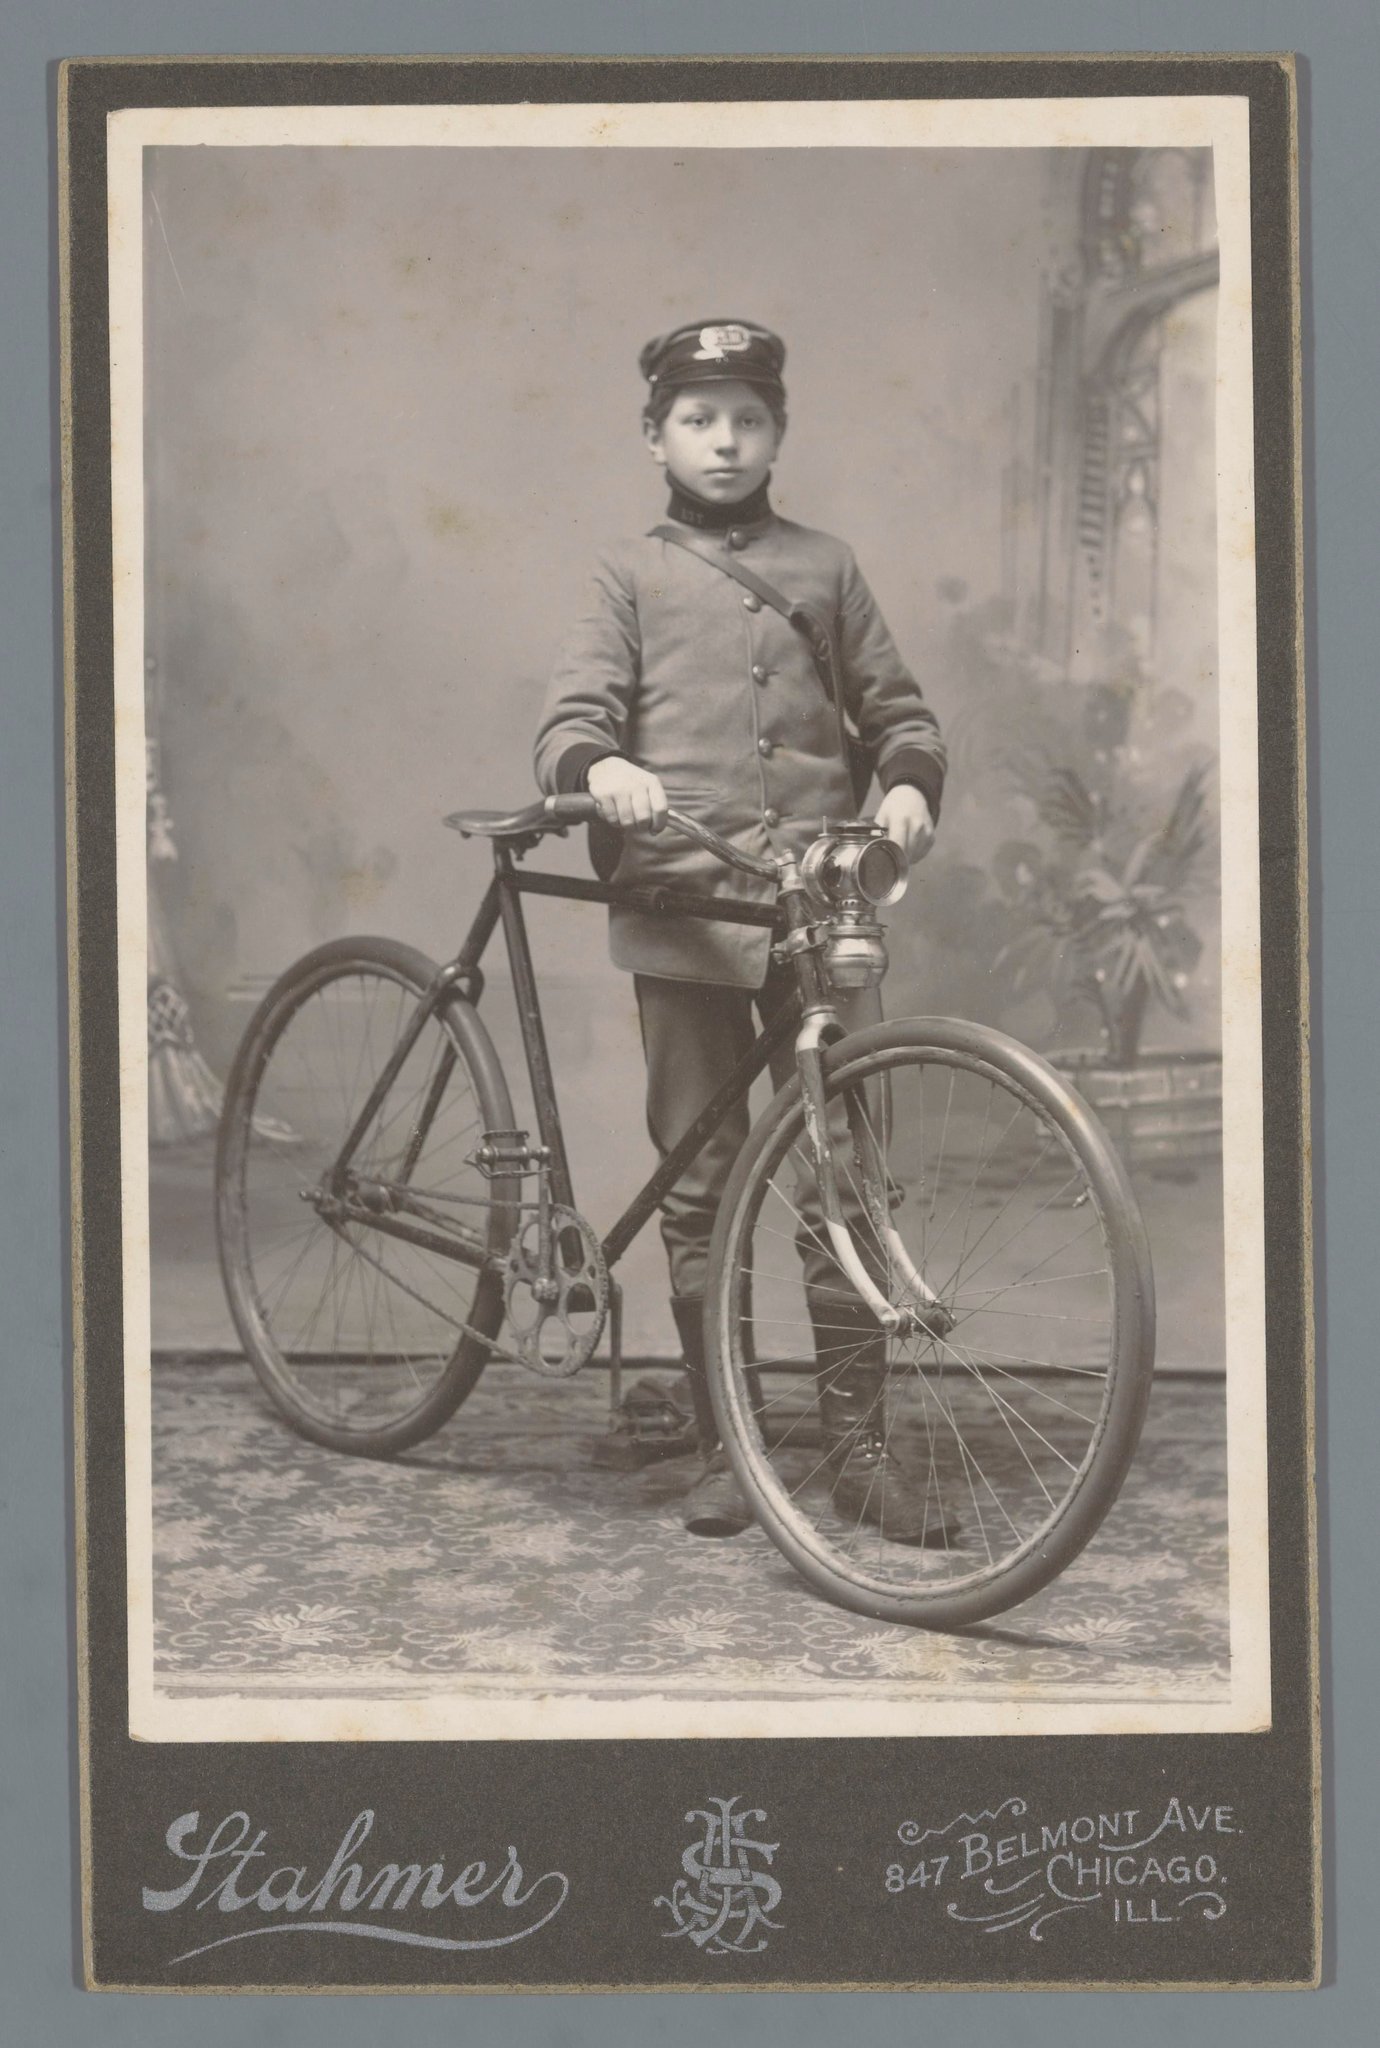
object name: photograph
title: Studioportret van een onbekende jongen in een uniform met een fiets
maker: stahmer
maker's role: fotograaf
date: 1895-1910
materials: cardboard, photographic support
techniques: matte daylight collodion silver print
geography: chicago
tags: boy (child between toddler and youth), bicycle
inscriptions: inscription: ‘Stahmer 847 Belmont Ave Chicago Ill’